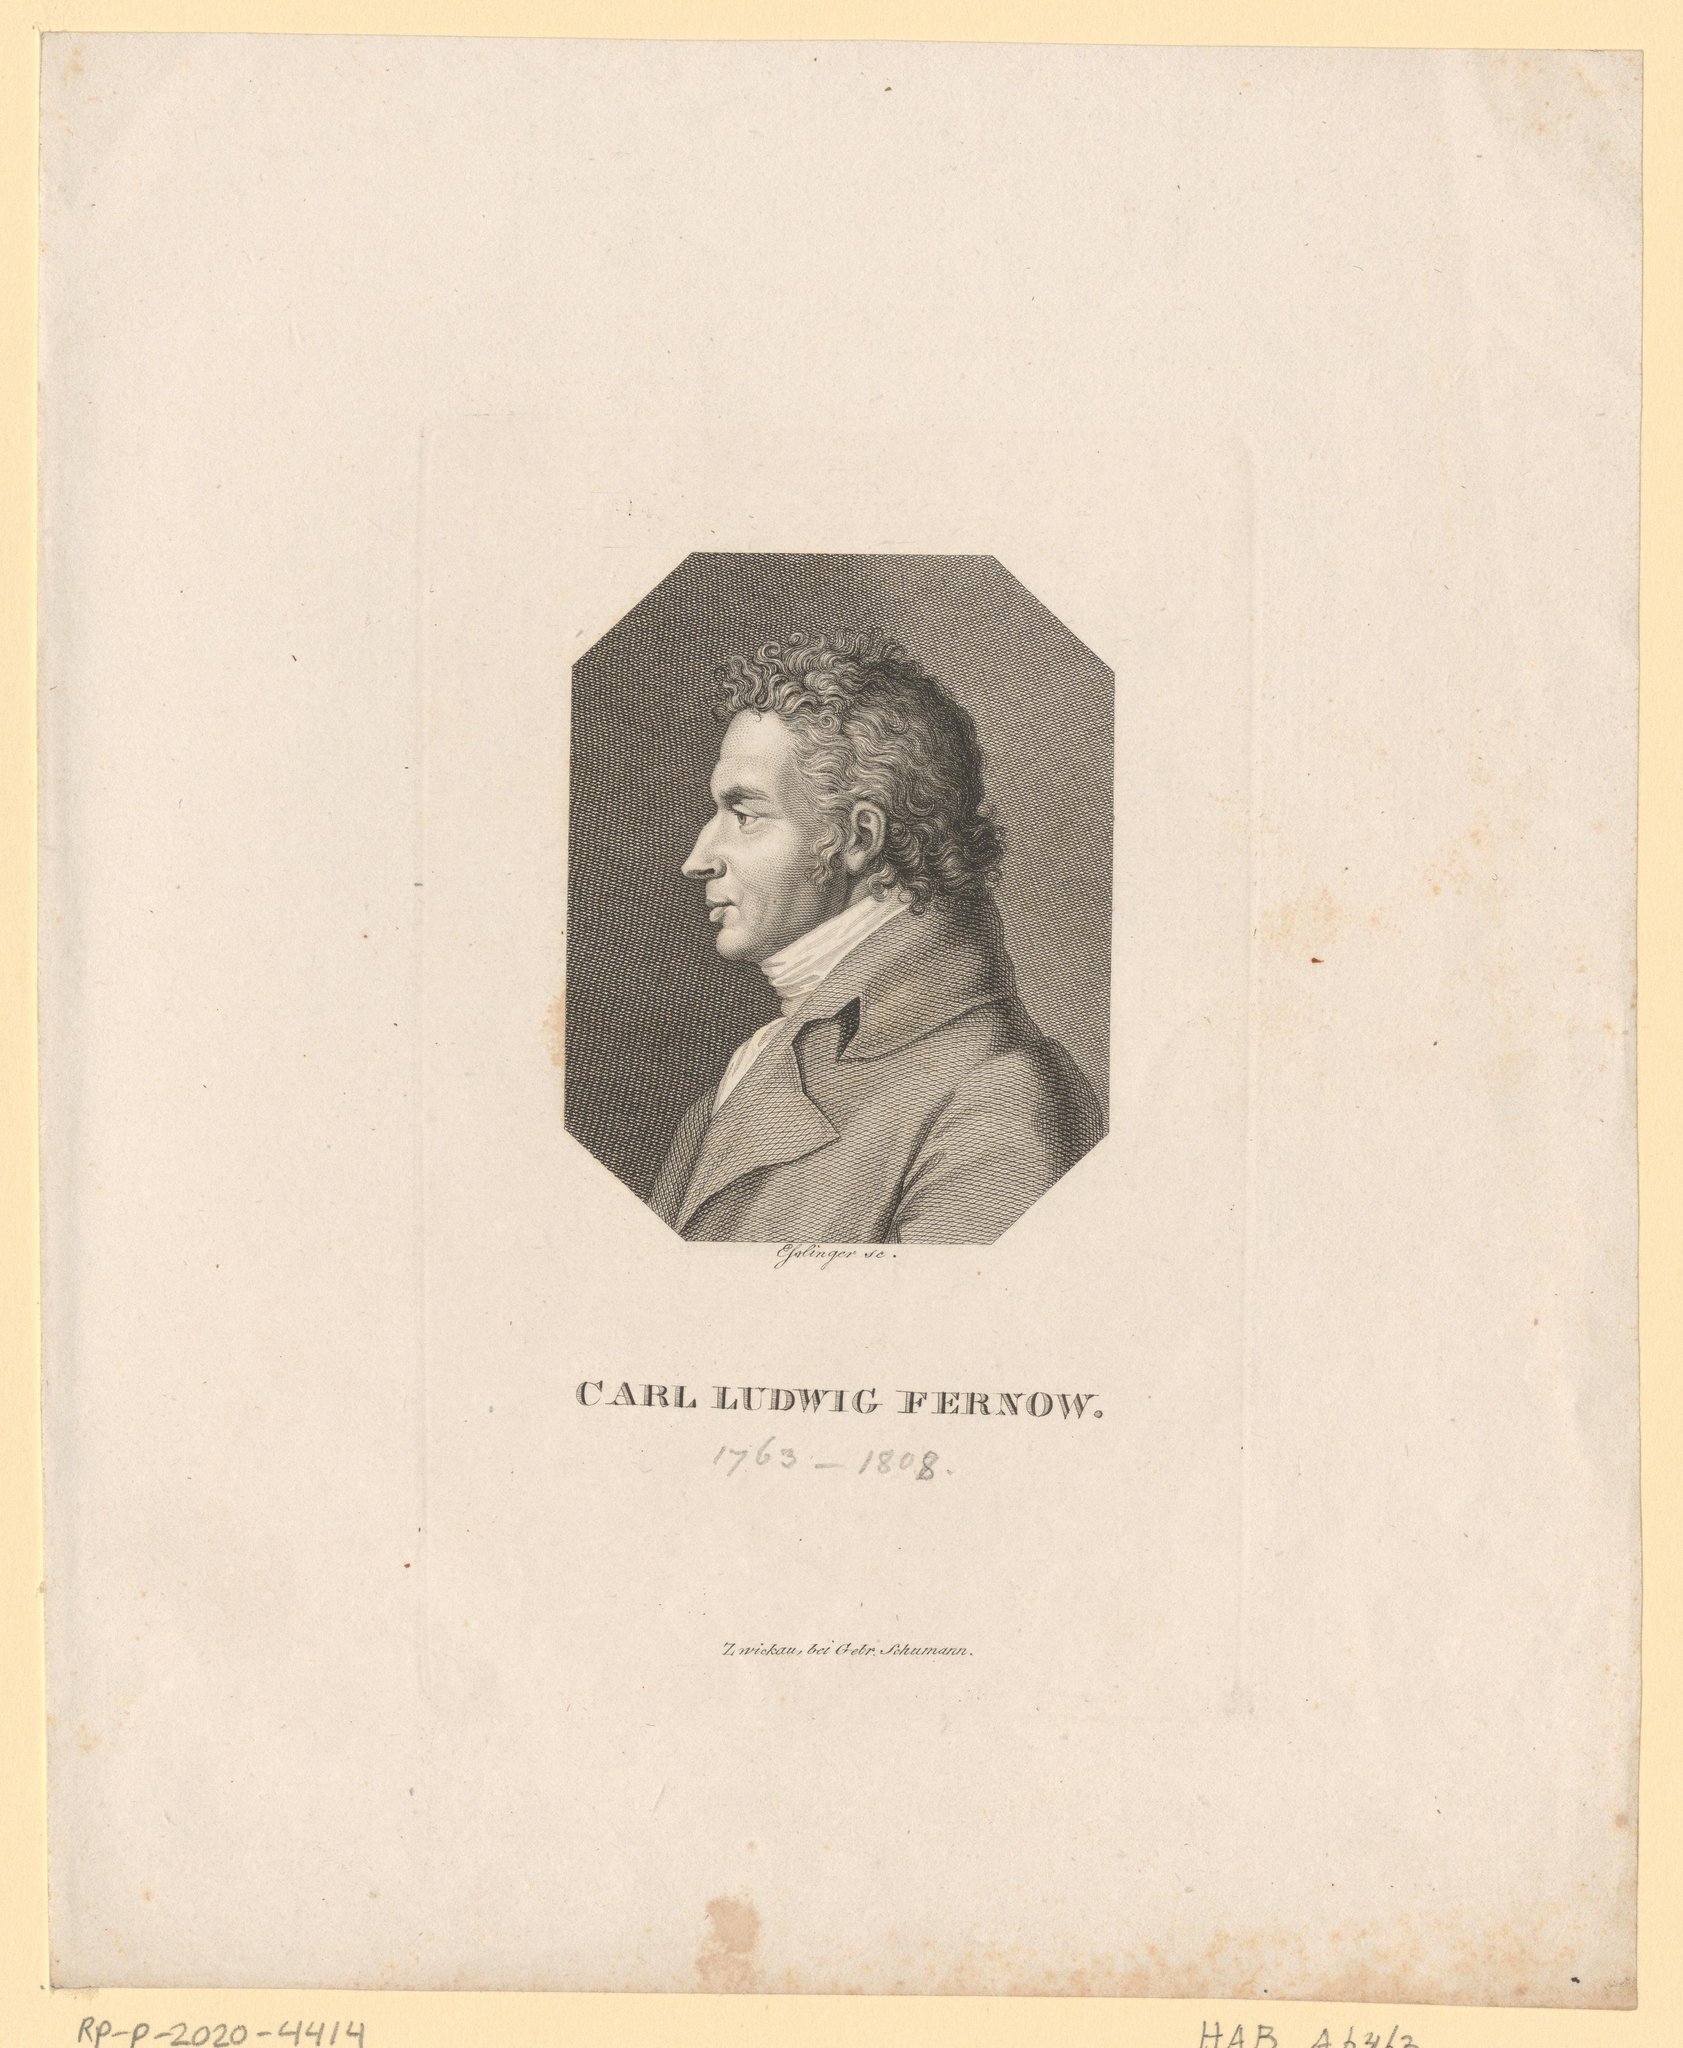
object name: print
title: Portret van Carl Ludwig Fernow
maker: martin esslinger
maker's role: print maker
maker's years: 1793-1841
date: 1818-1832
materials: paper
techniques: engraving, etching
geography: germany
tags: historical persons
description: De serie werd in 35 delen uitgegeven tussen 1818 en 1832.